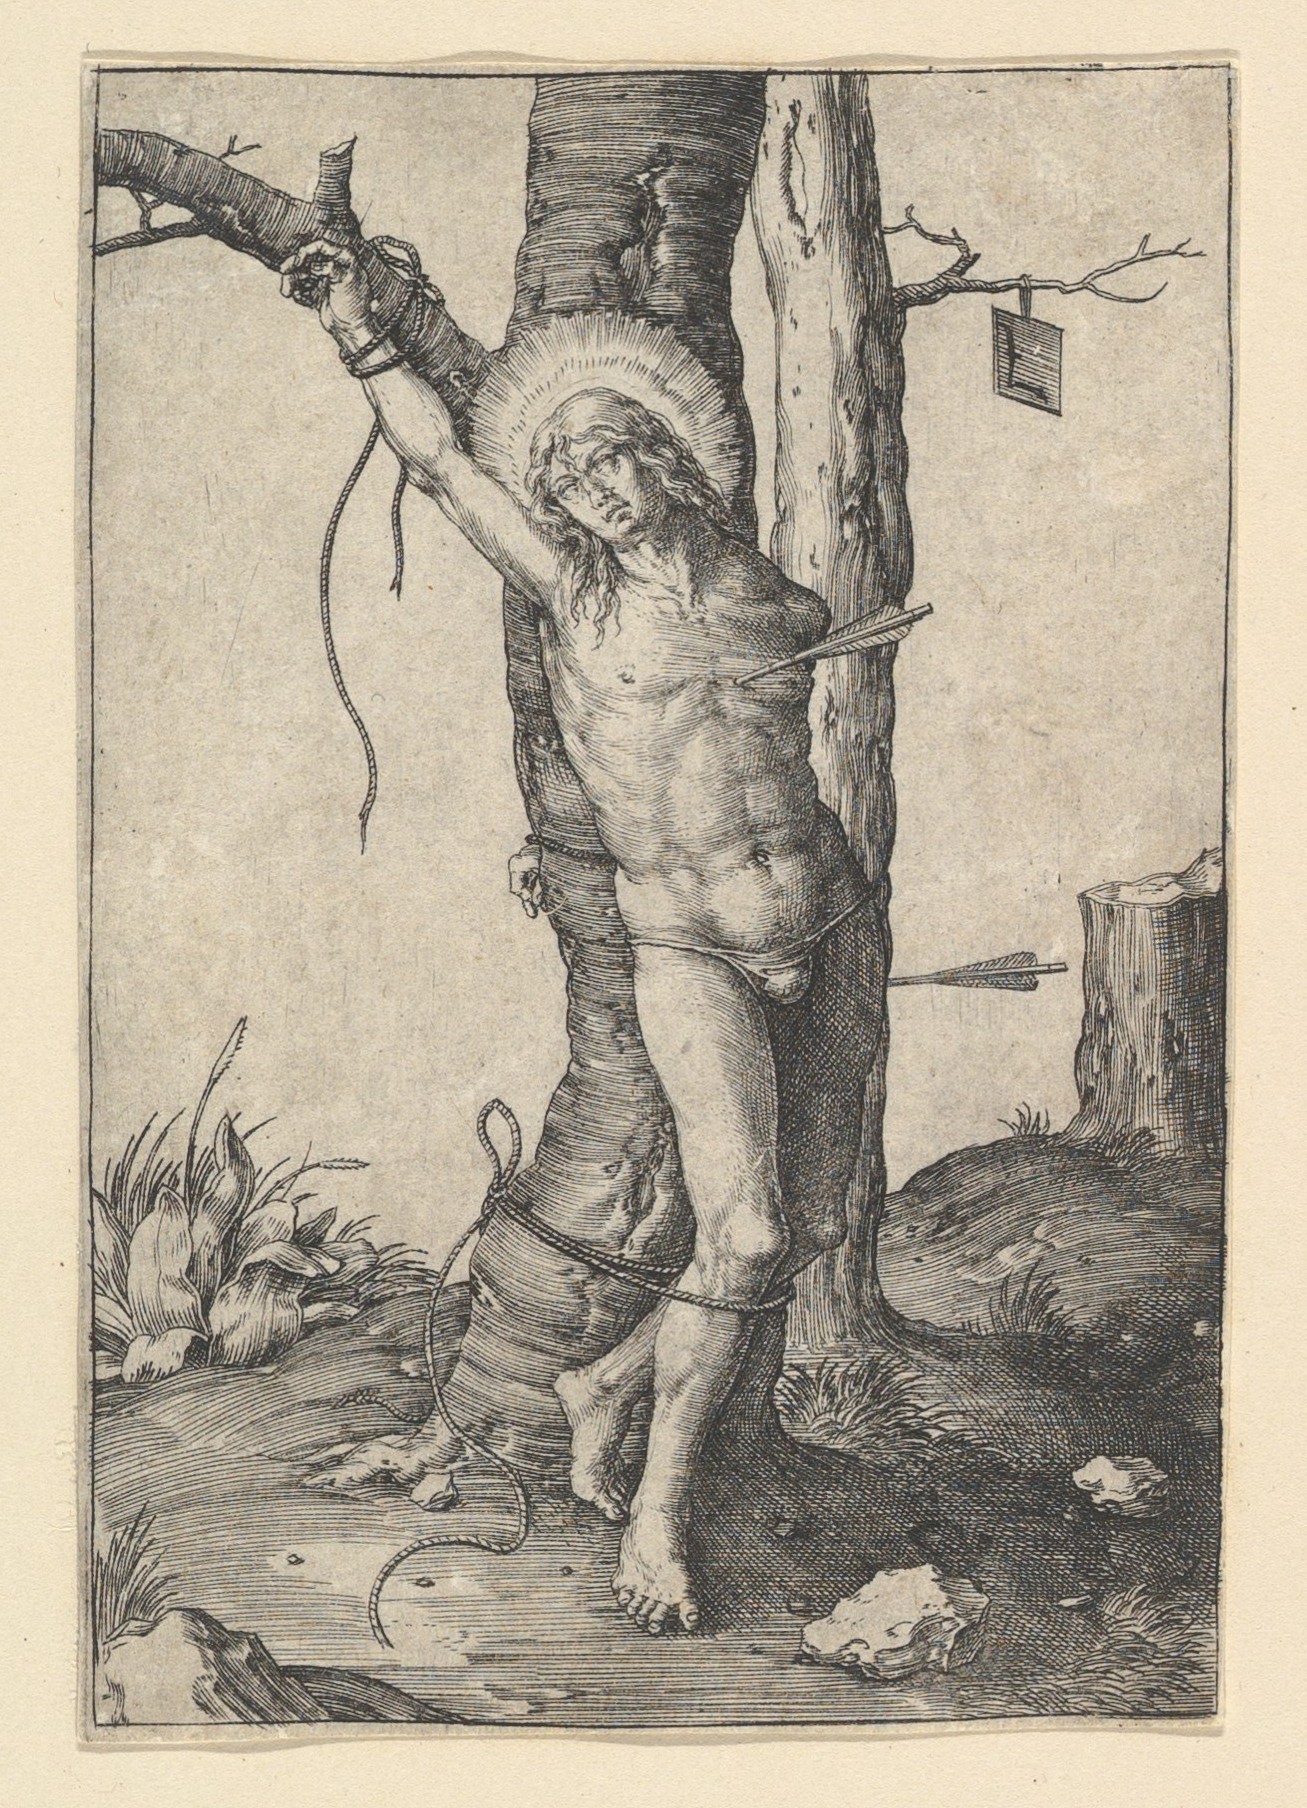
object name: print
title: St. Sebastian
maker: lucas van leyden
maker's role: artist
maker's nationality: netherlandish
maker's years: 1494-1533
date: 1510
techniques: engraving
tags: suffering,saints